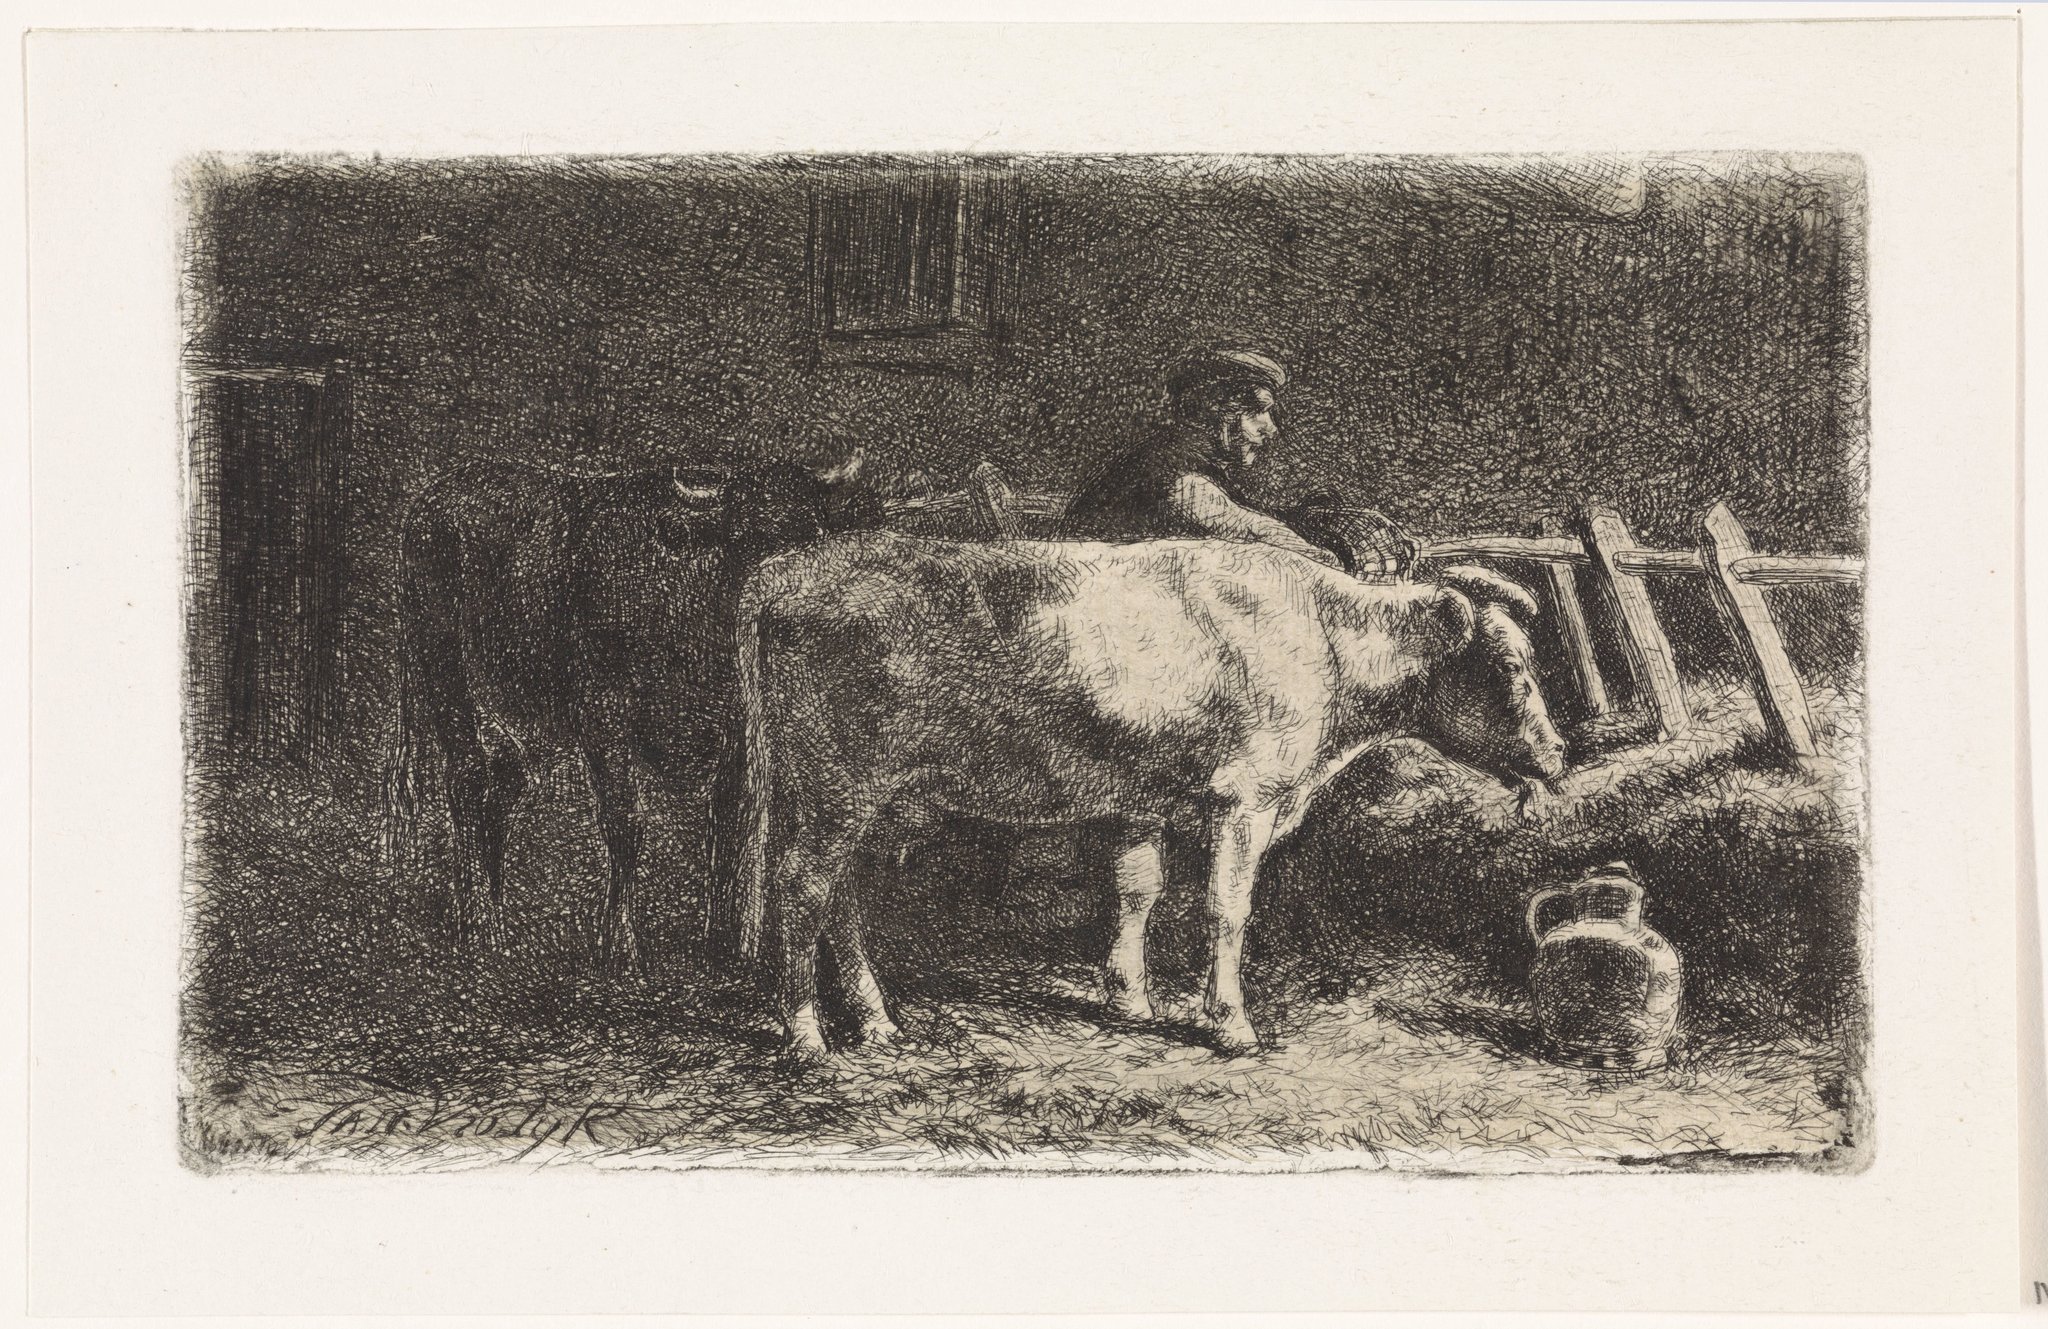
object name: print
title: Boer tussen twee koeien bij een ruif in een stal (grote variant)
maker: jan vrolijk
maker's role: draughtsman, painter, print maker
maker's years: 1846-1894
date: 1860-1885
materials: paper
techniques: etching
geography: the hague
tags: cow, farmers, stall, stable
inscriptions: collector's mark: Lugt 2228